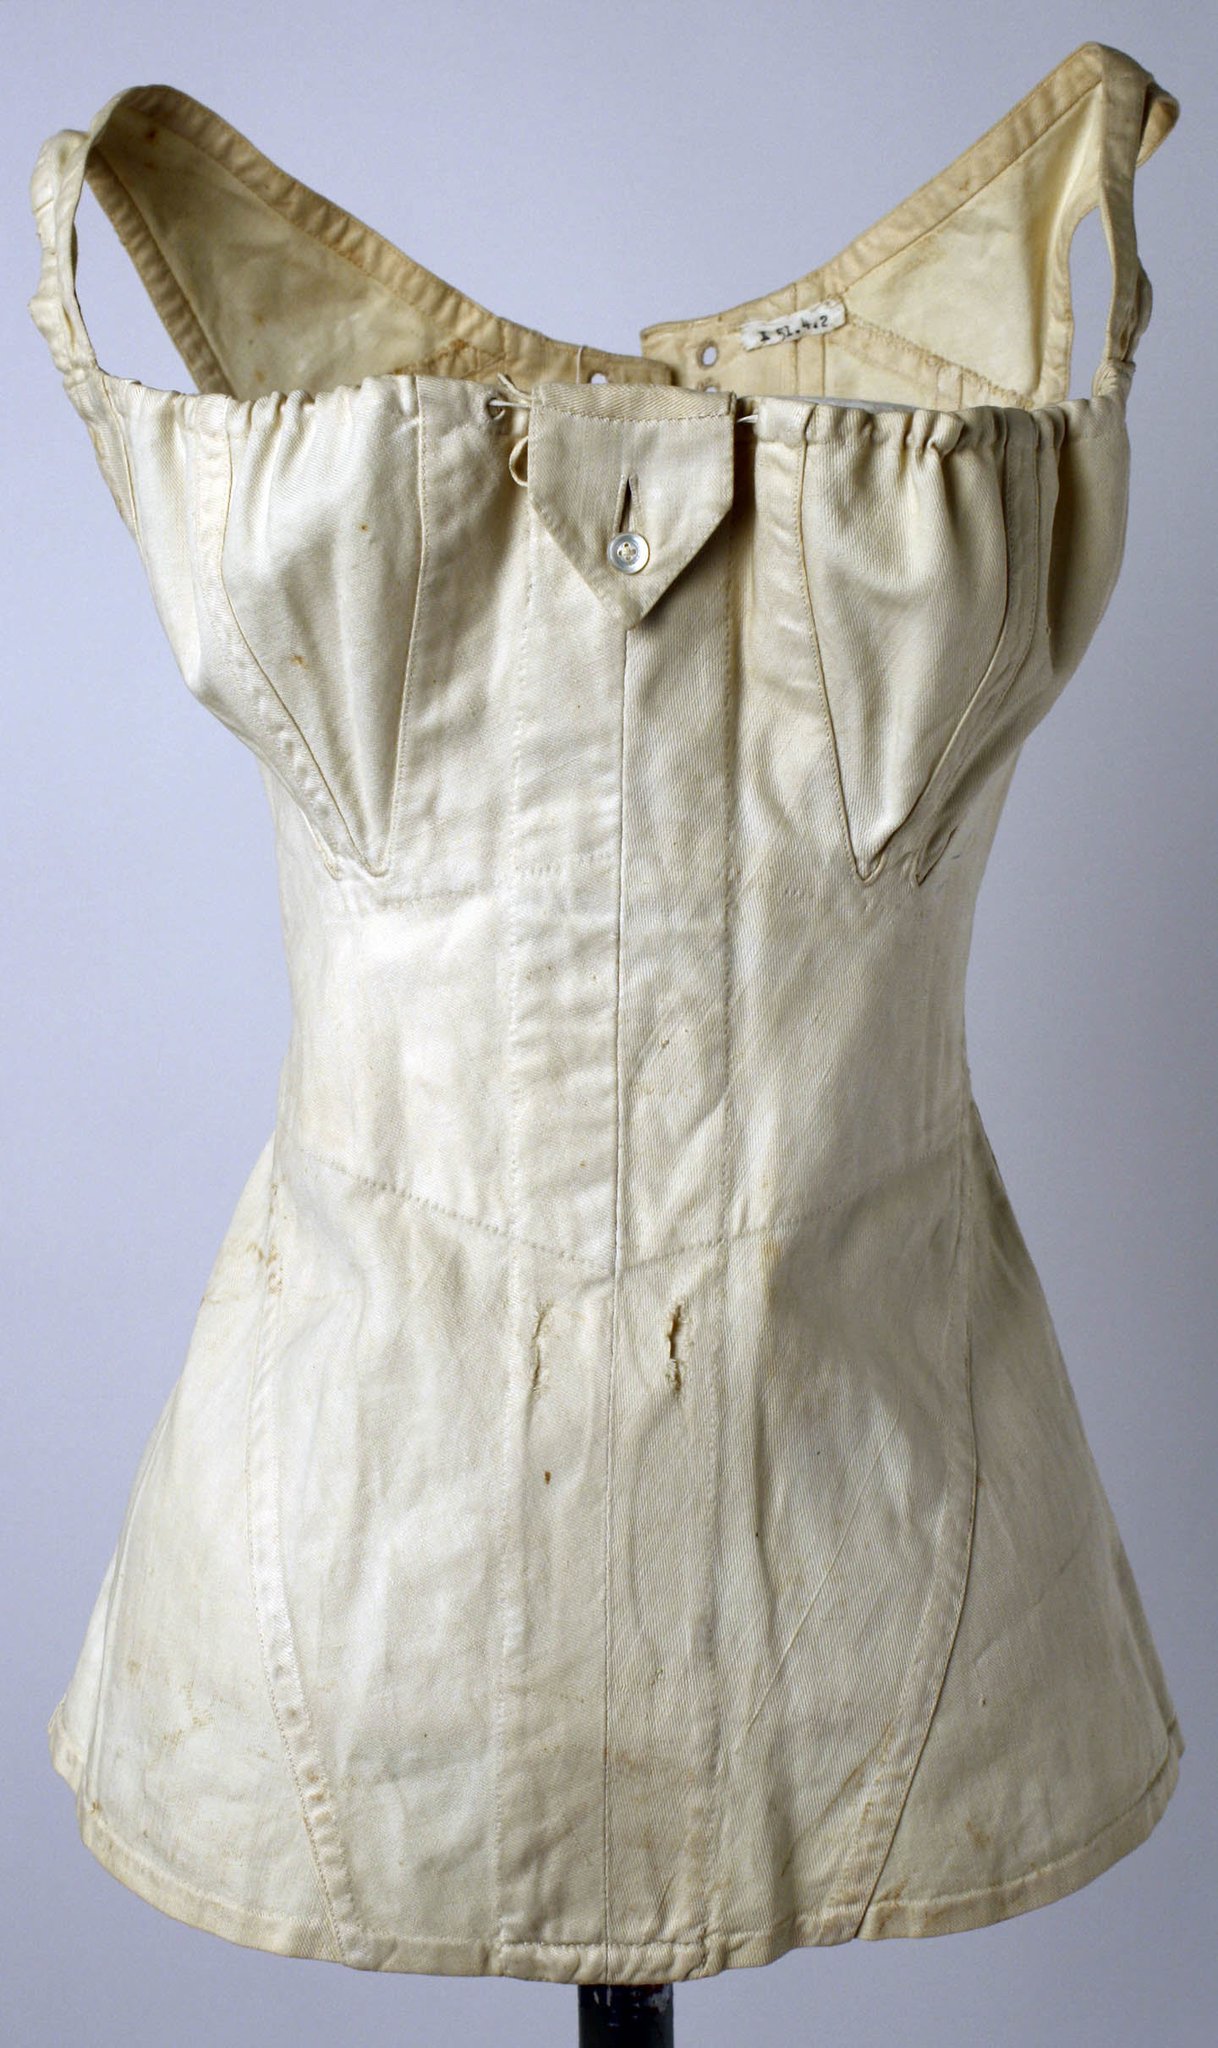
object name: corset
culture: american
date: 1811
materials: cotton